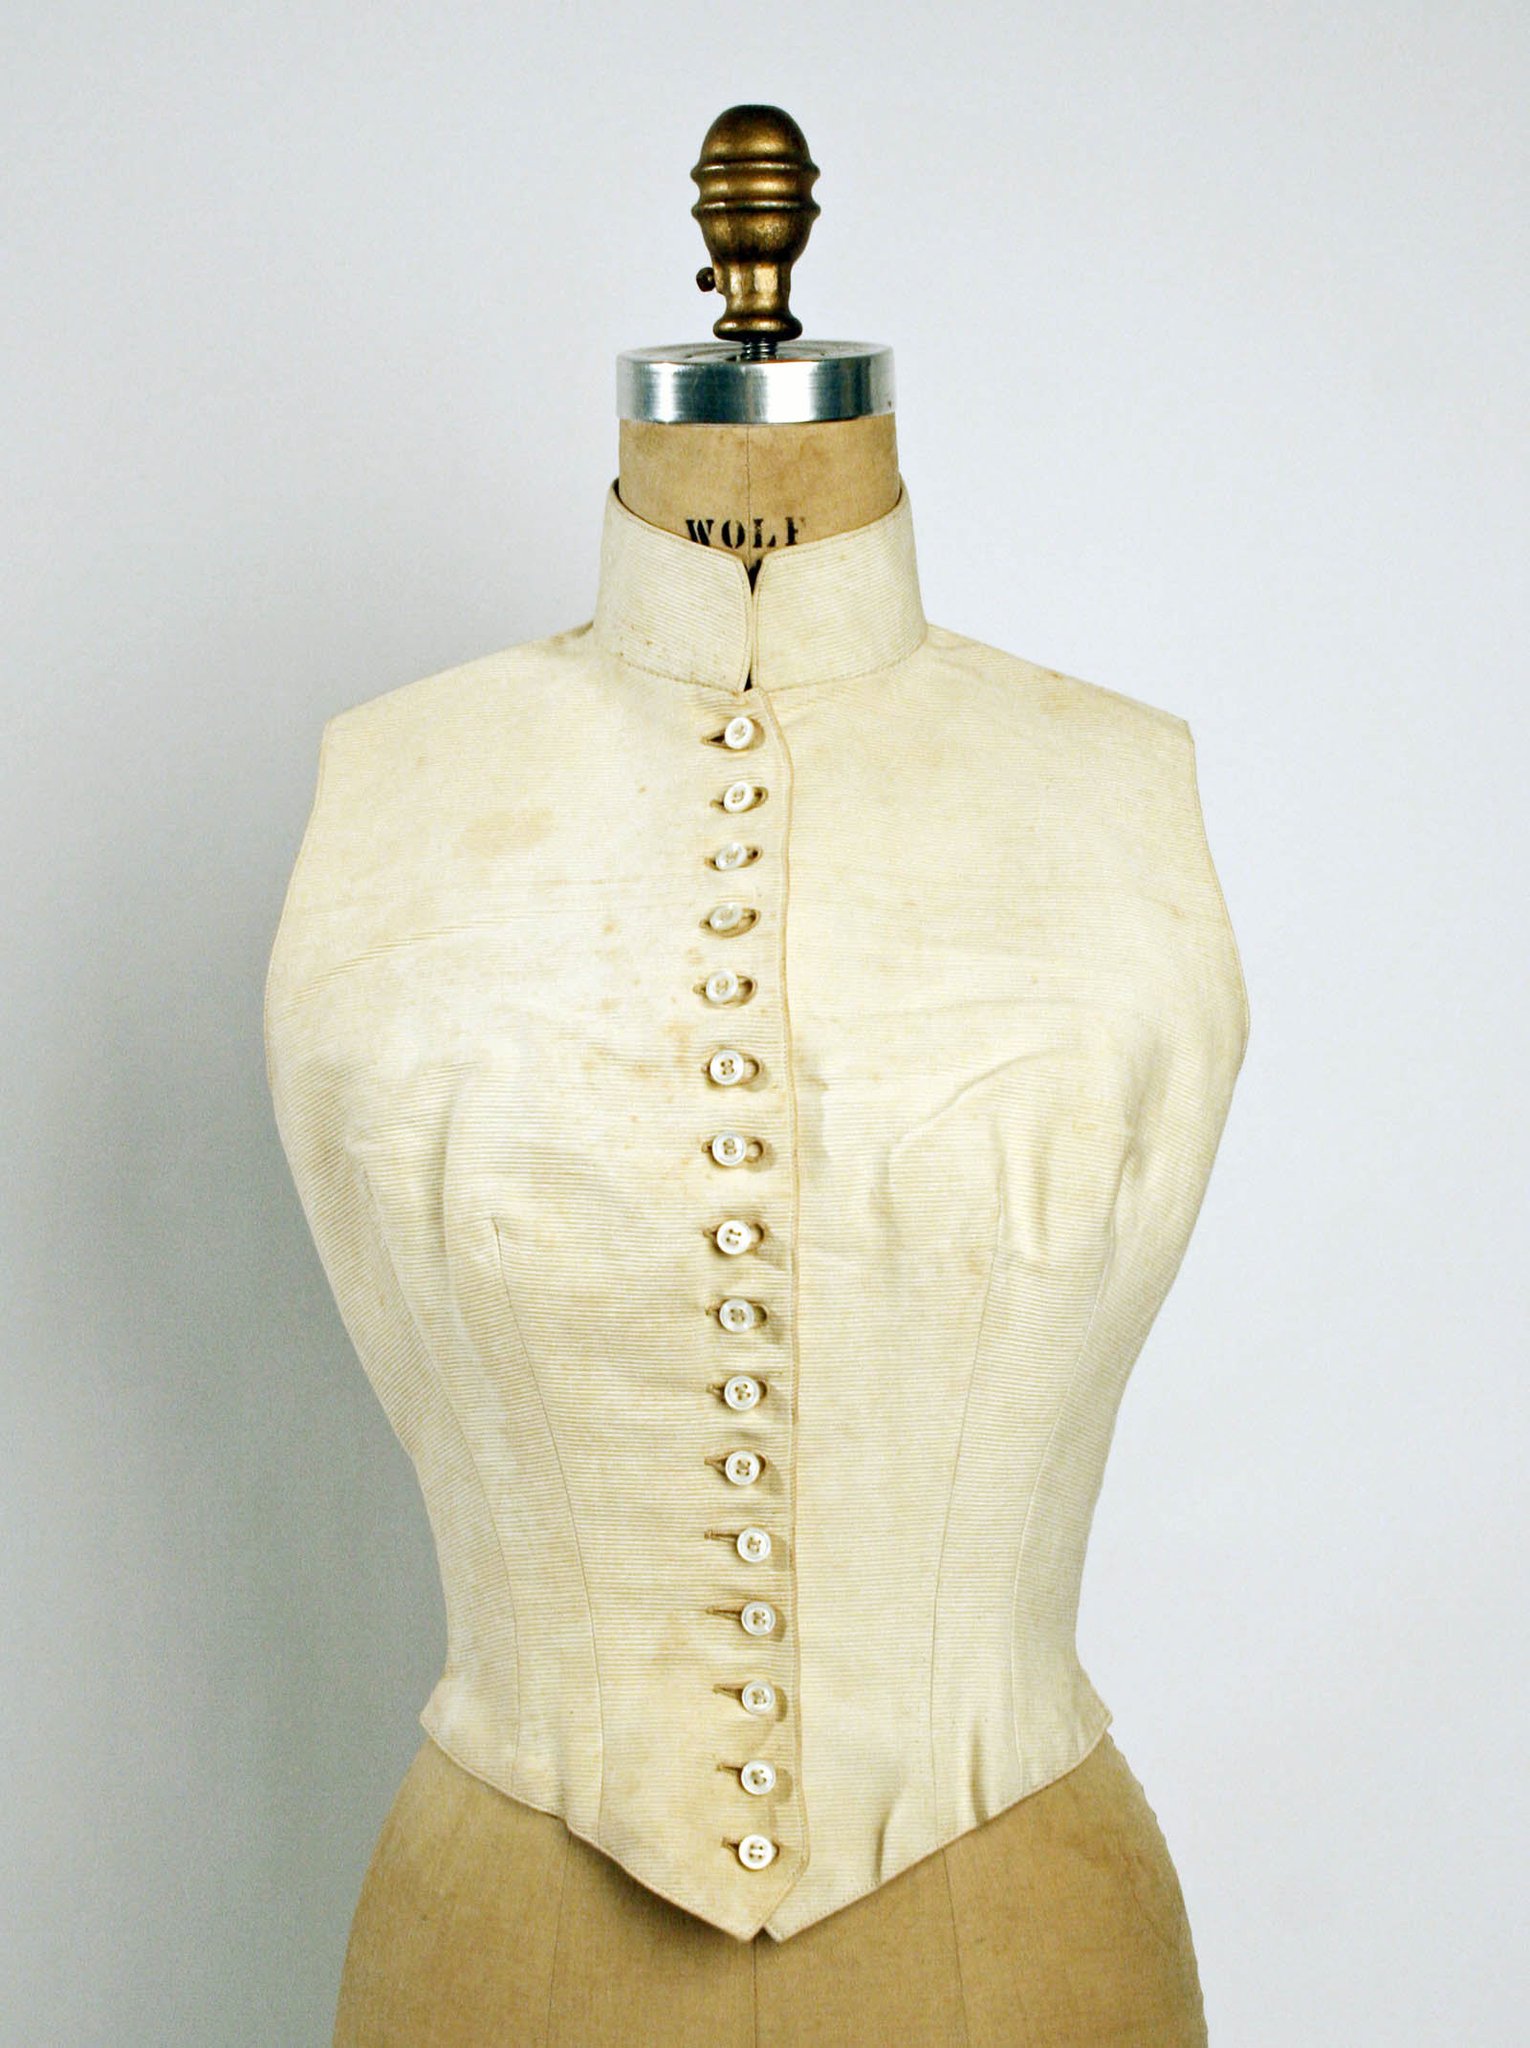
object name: vest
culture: american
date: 1890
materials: cotton